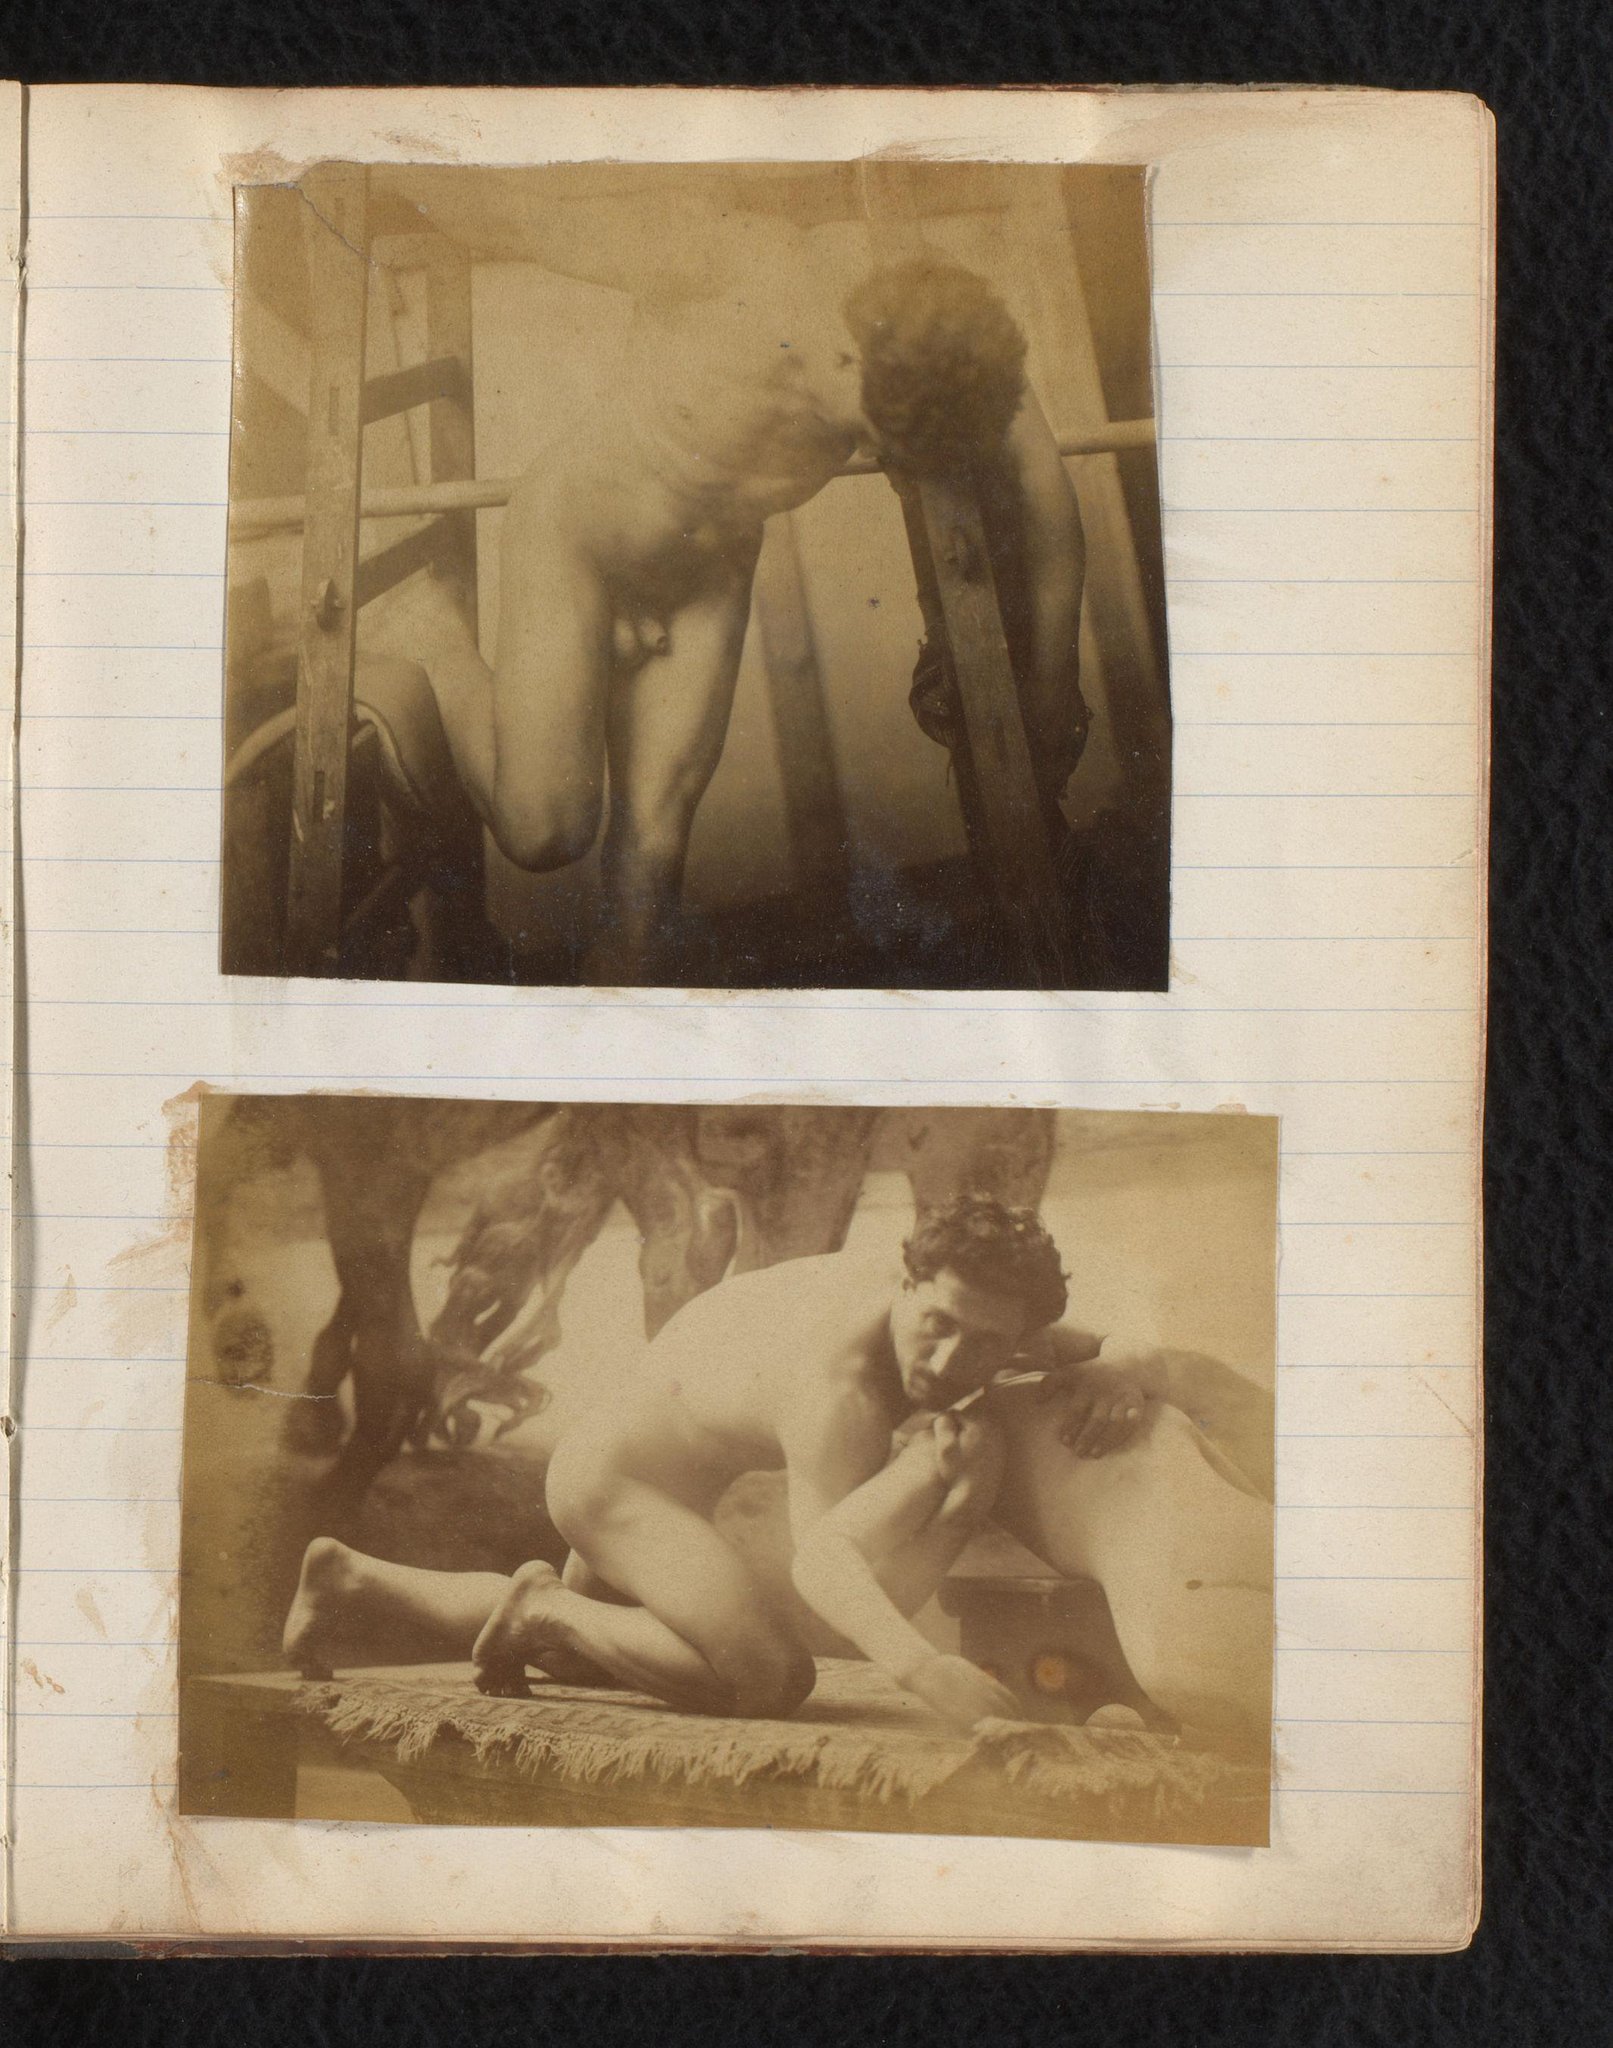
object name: photograph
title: Studie van een mannelijk naaktmodel, voorover hangend in een houten stellage, in het atelier van Jacques de Lalaing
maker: jacques lalaing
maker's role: painter, sculptor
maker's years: 1858-1917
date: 1883-1914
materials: photographic support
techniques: albumen print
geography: brussels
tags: adult woman, artist (in general) working from nude model